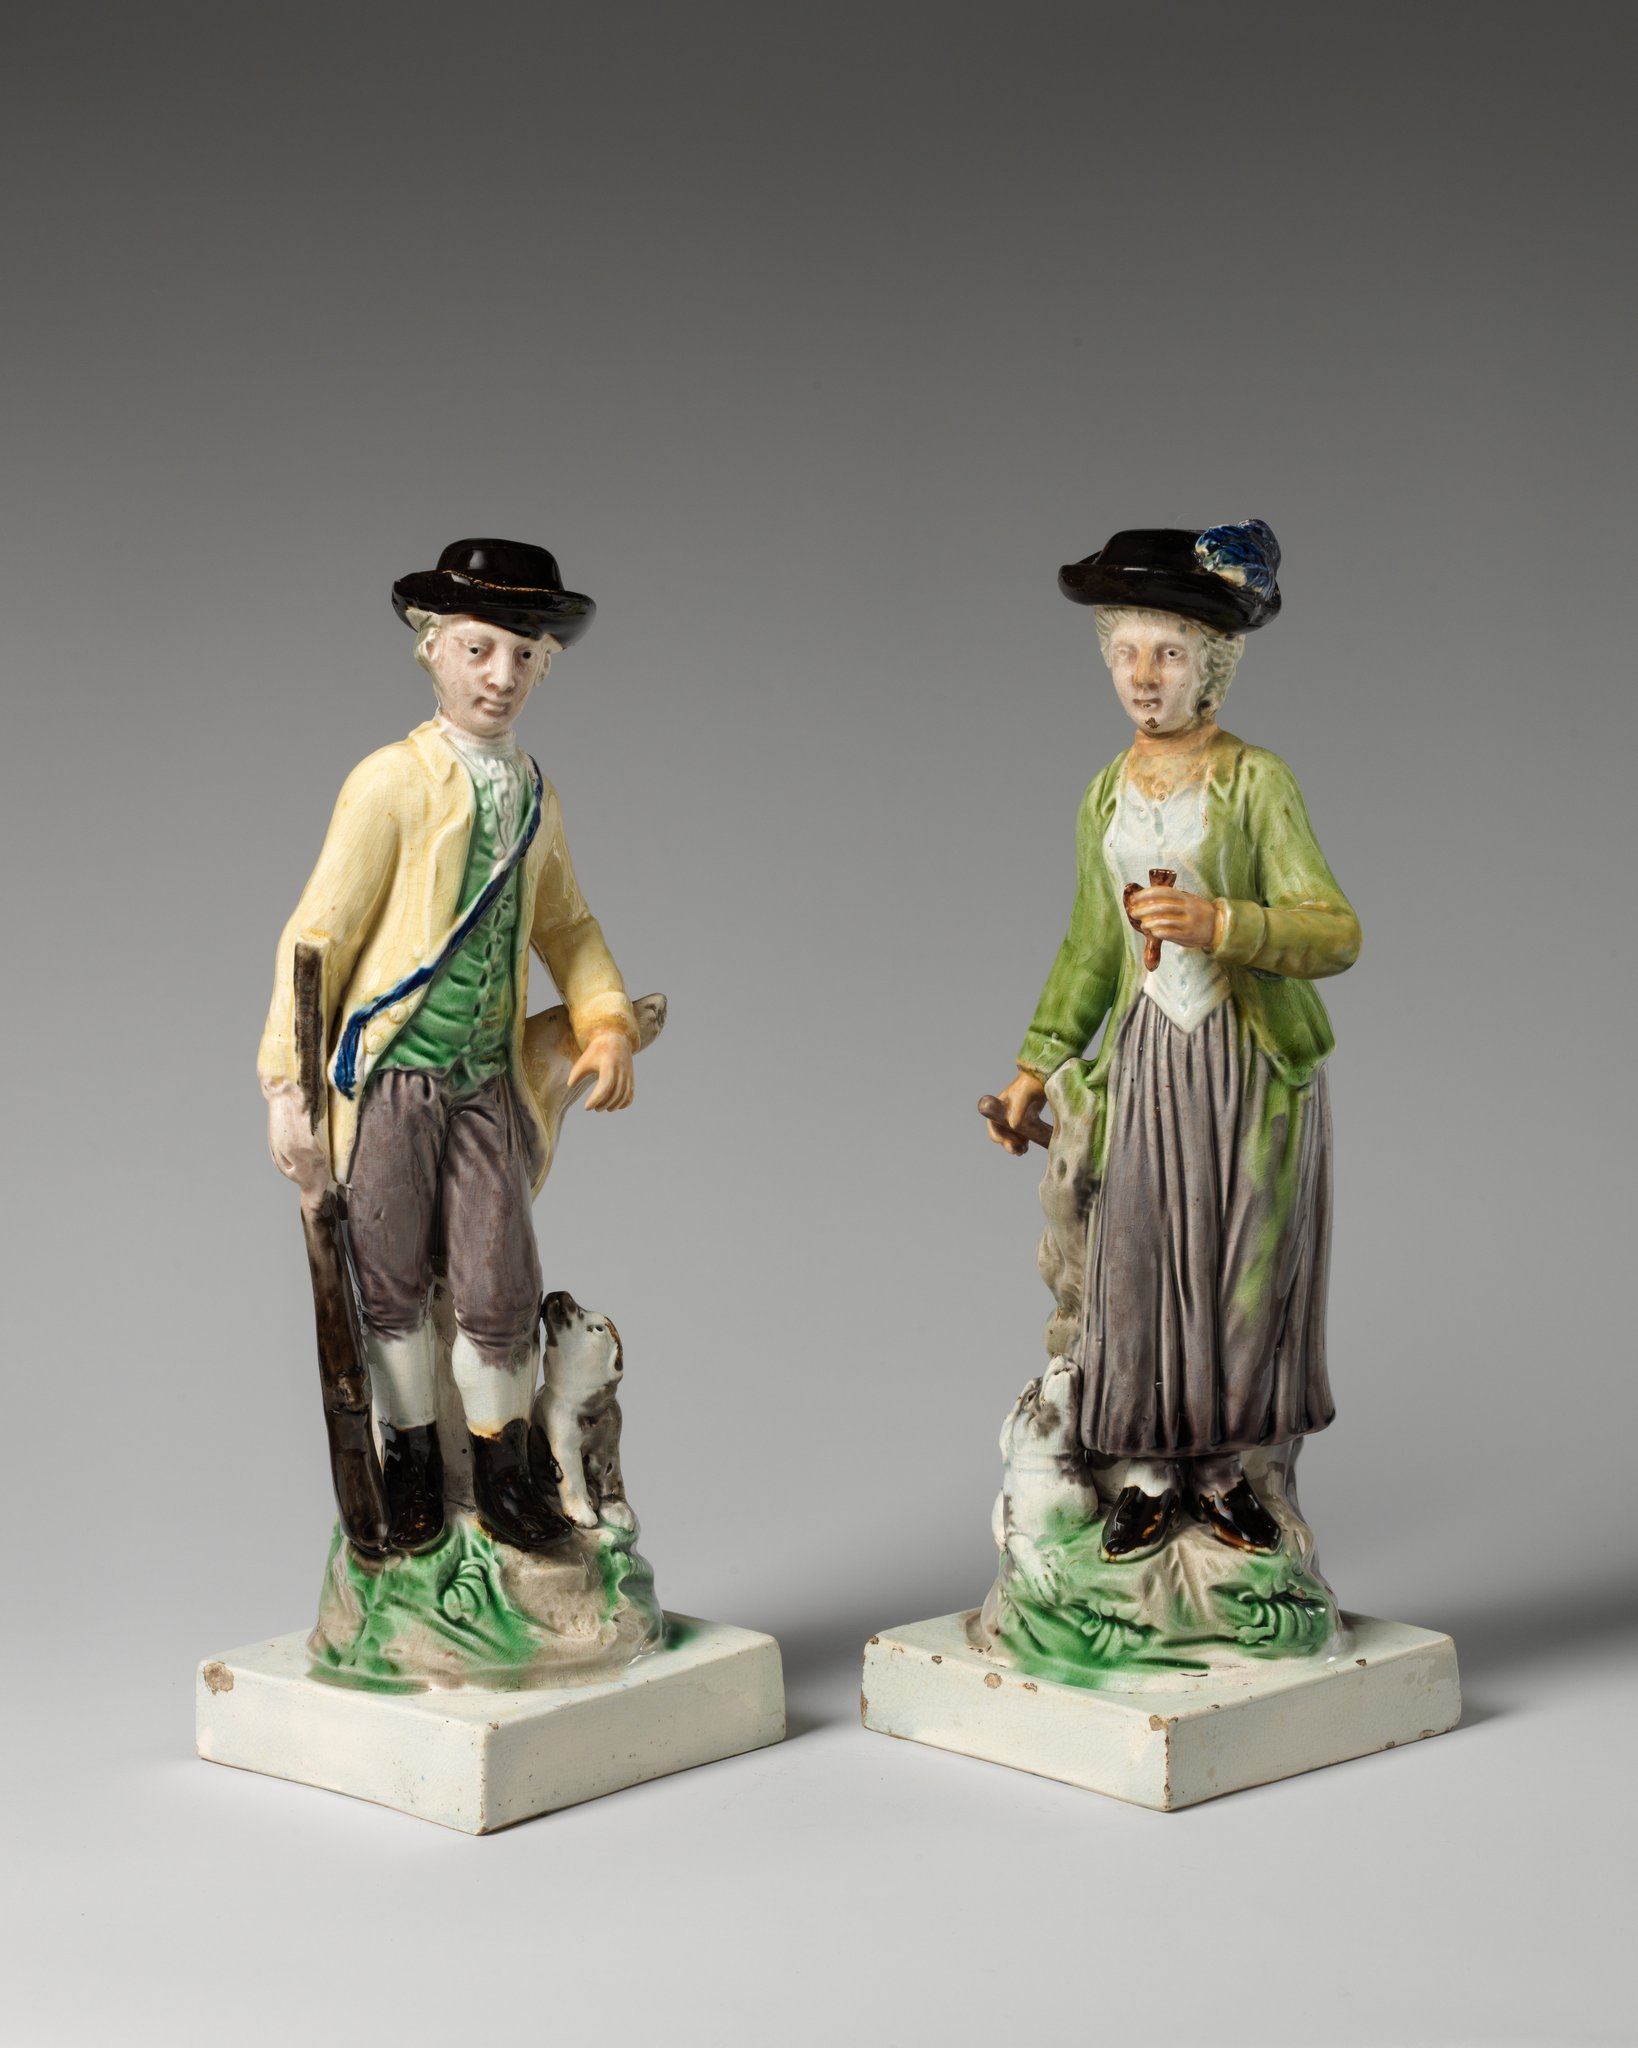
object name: figure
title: Sportsman and sportswoman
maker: ralph wood the younger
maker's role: maker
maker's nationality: british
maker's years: 1748-1795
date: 1780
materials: earthenware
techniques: glazing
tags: men,women